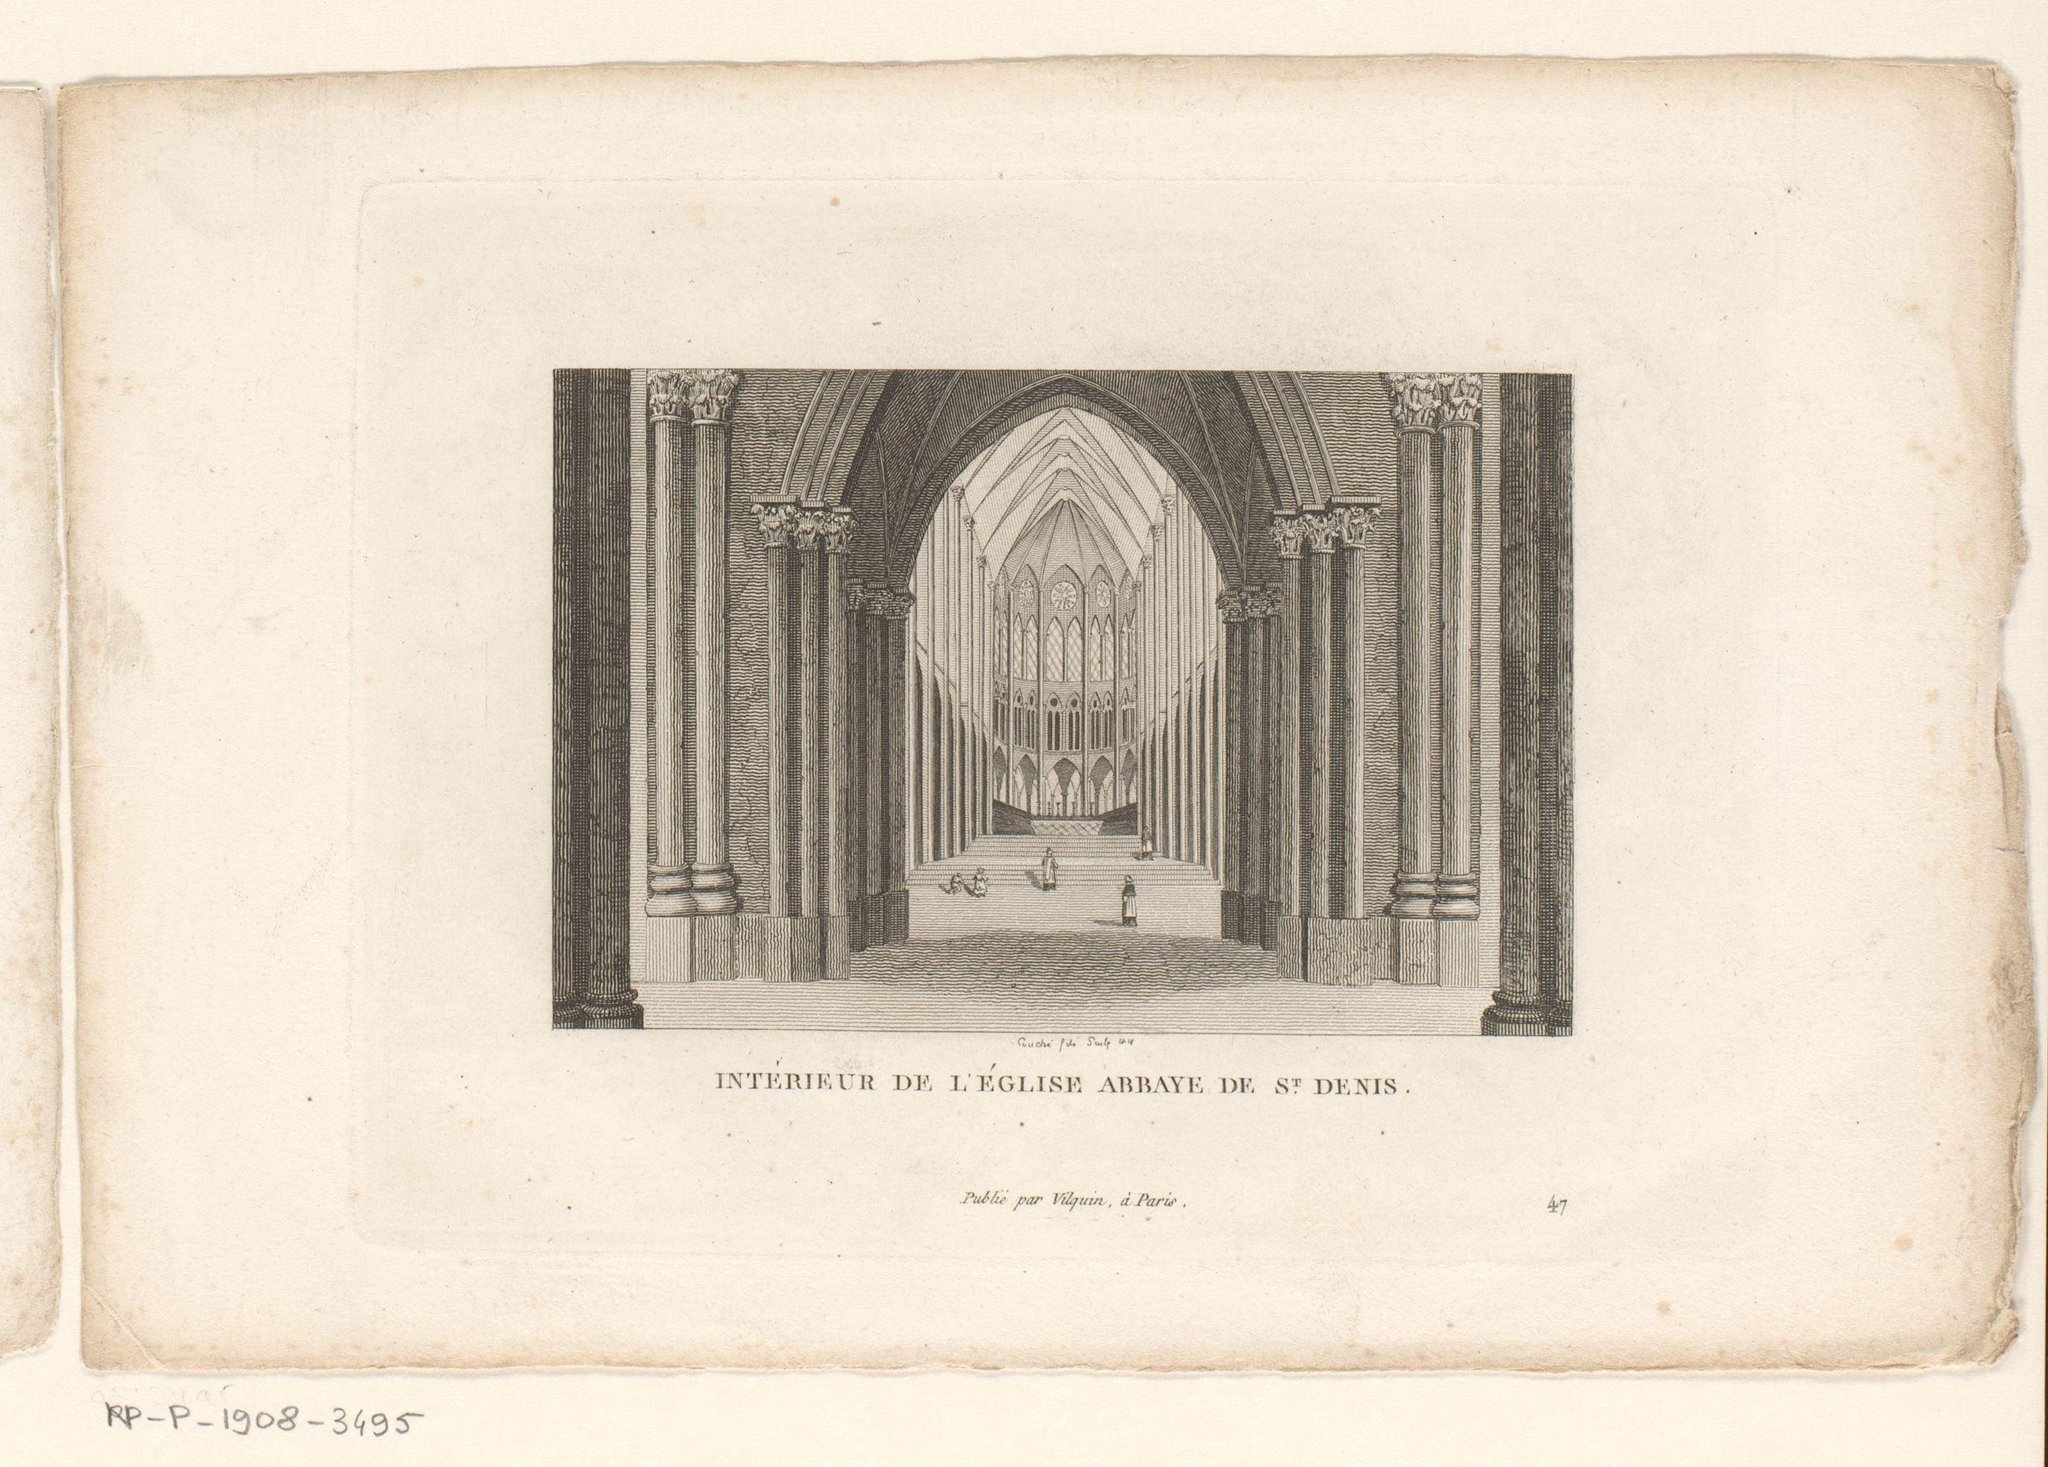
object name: print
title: Gezicht op het interieur van de Kathedraal van Saint-Denis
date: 1818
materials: paper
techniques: etching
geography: paris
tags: interior of church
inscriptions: collector's mark: Lugt 2228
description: Maakt deel uit van een serie met 60 platen van monumenten, kathedralen en paleizen in Parijs.